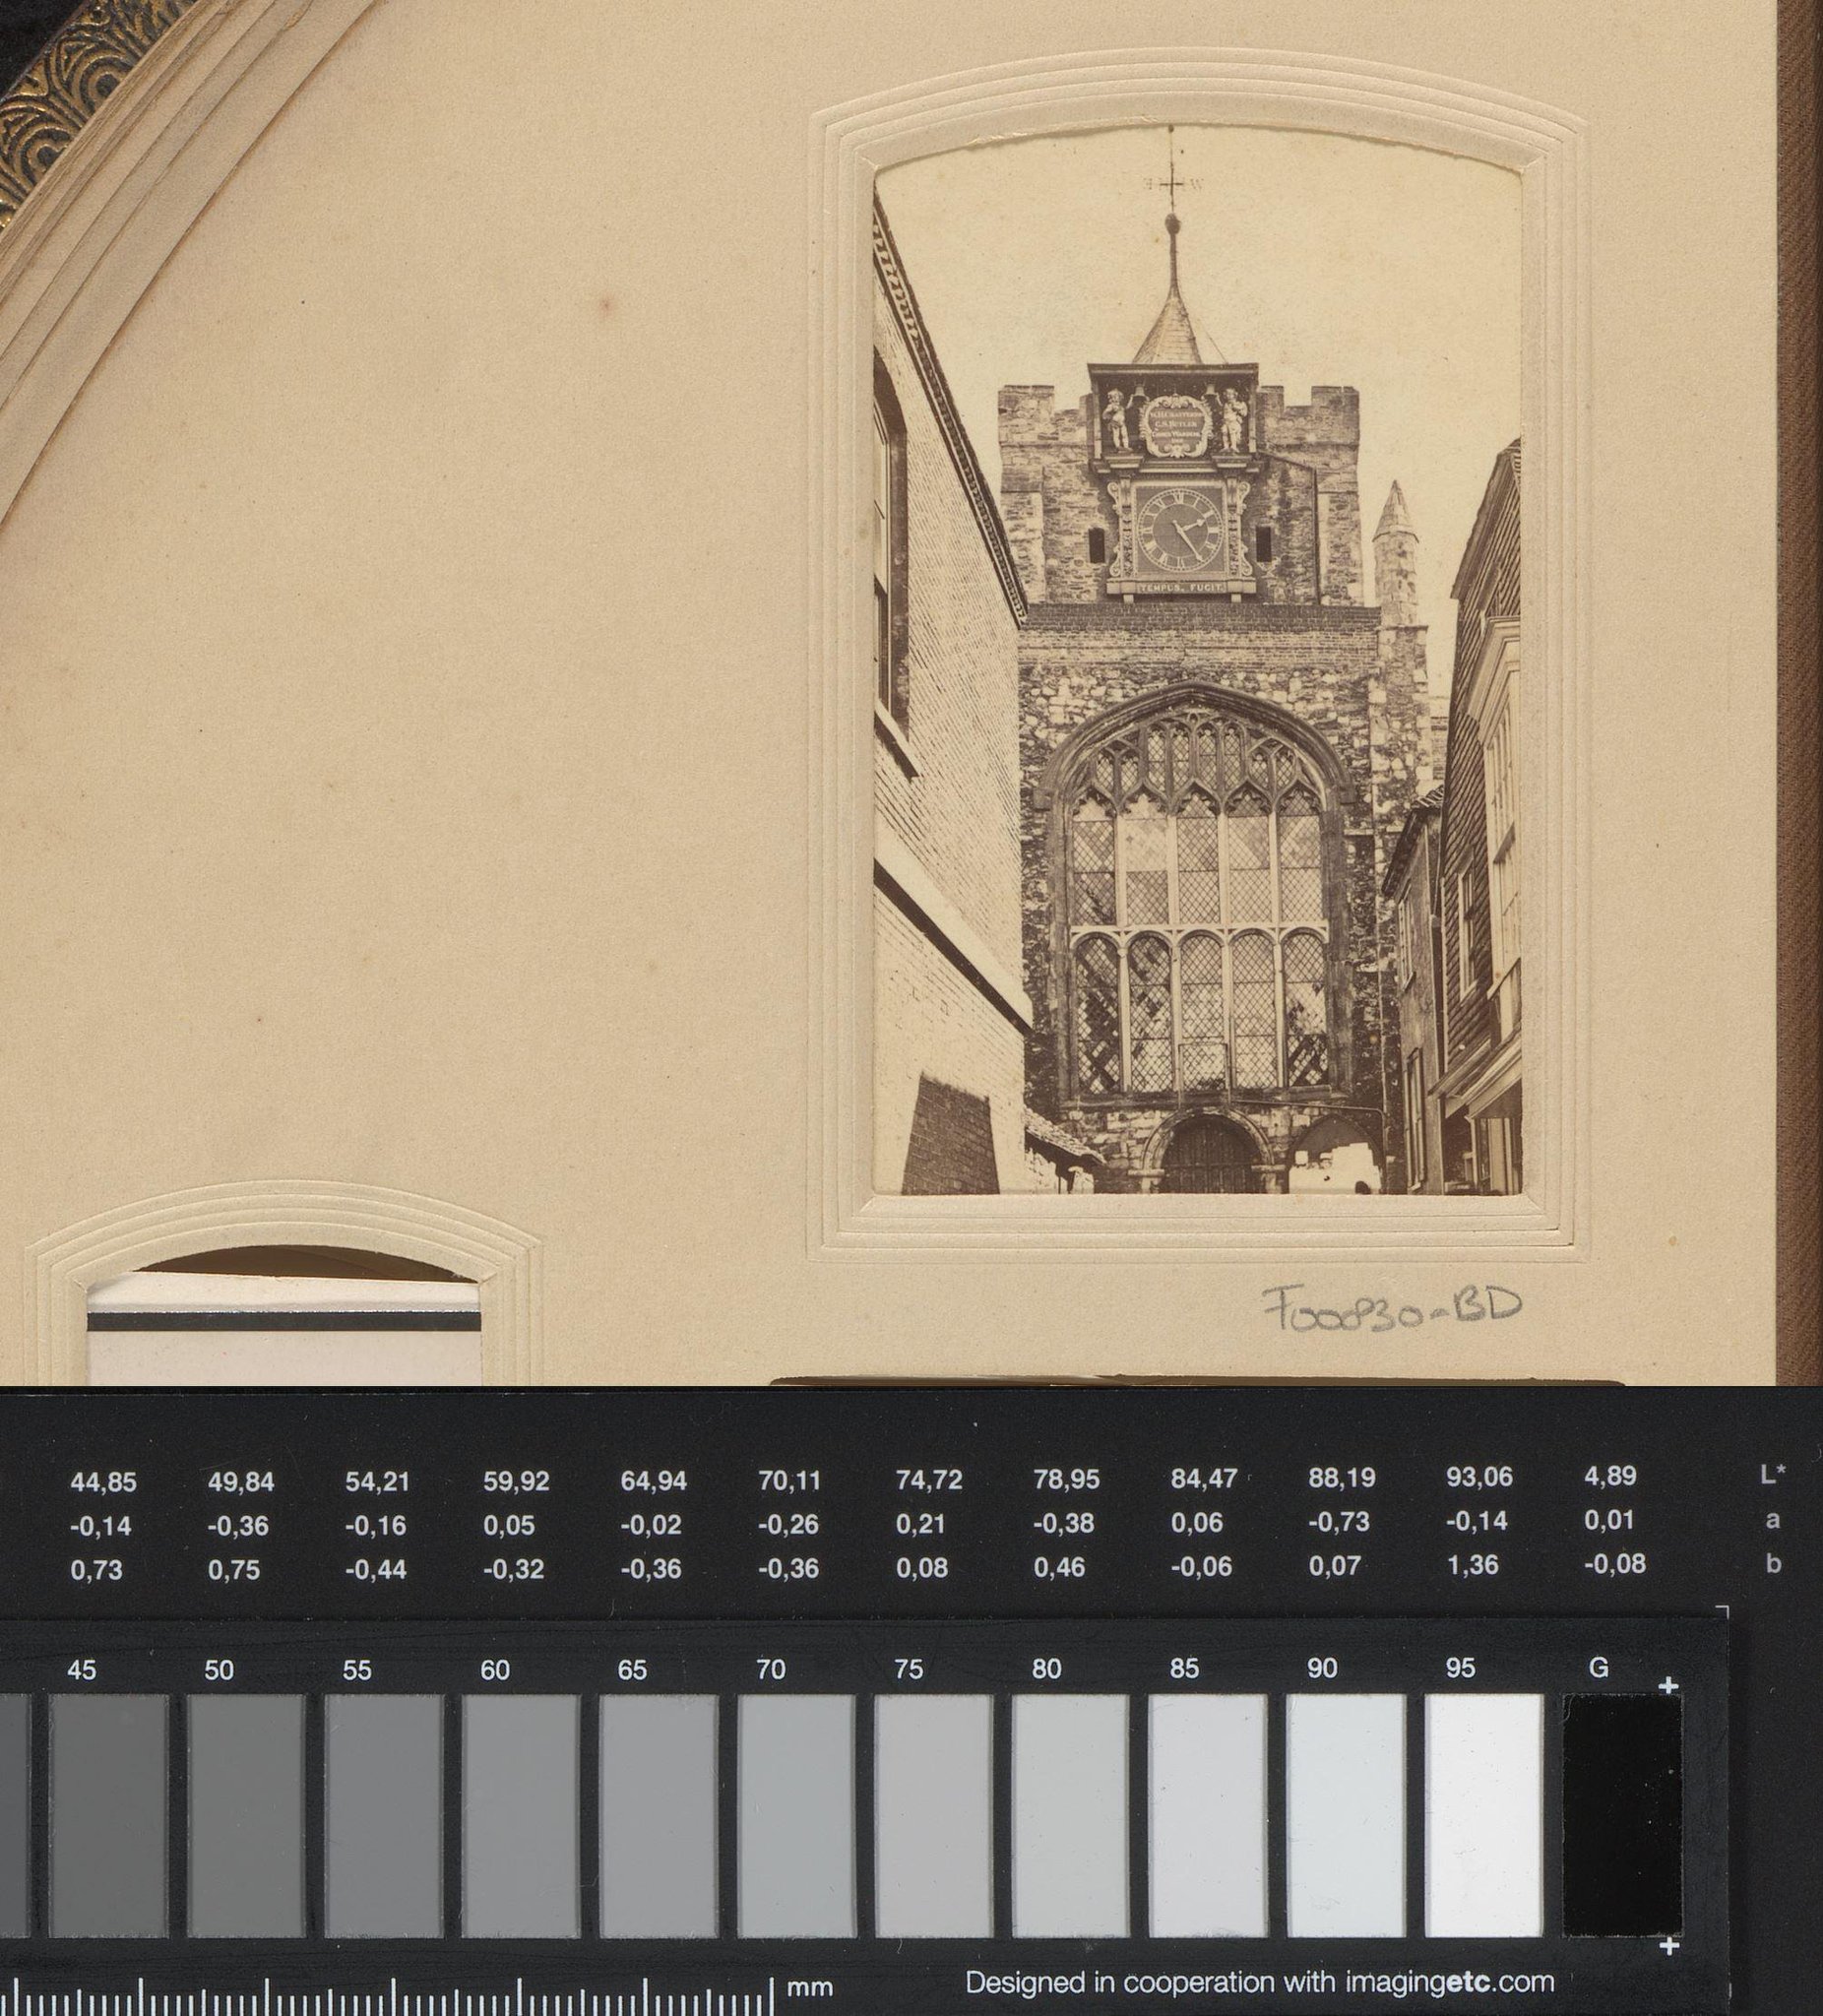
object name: album leaf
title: Gezicht op St. Mary's Church te Rye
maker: e.t. casson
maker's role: fotograaf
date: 1870-1890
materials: cardboard, photographic support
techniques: albumen print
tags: church (exterior)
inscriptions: annotation: ‘Rye Church/ [...]’, inscription: ‘E.T. Casson/ Naturalist &/ Photographic Artist/ 21, King Street/ Rye, Sussex’